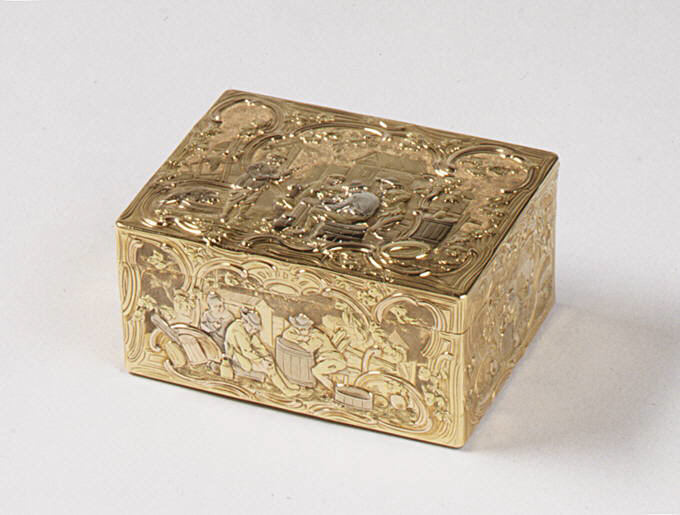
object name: snuffbox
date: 1757-1758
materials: gold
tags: men